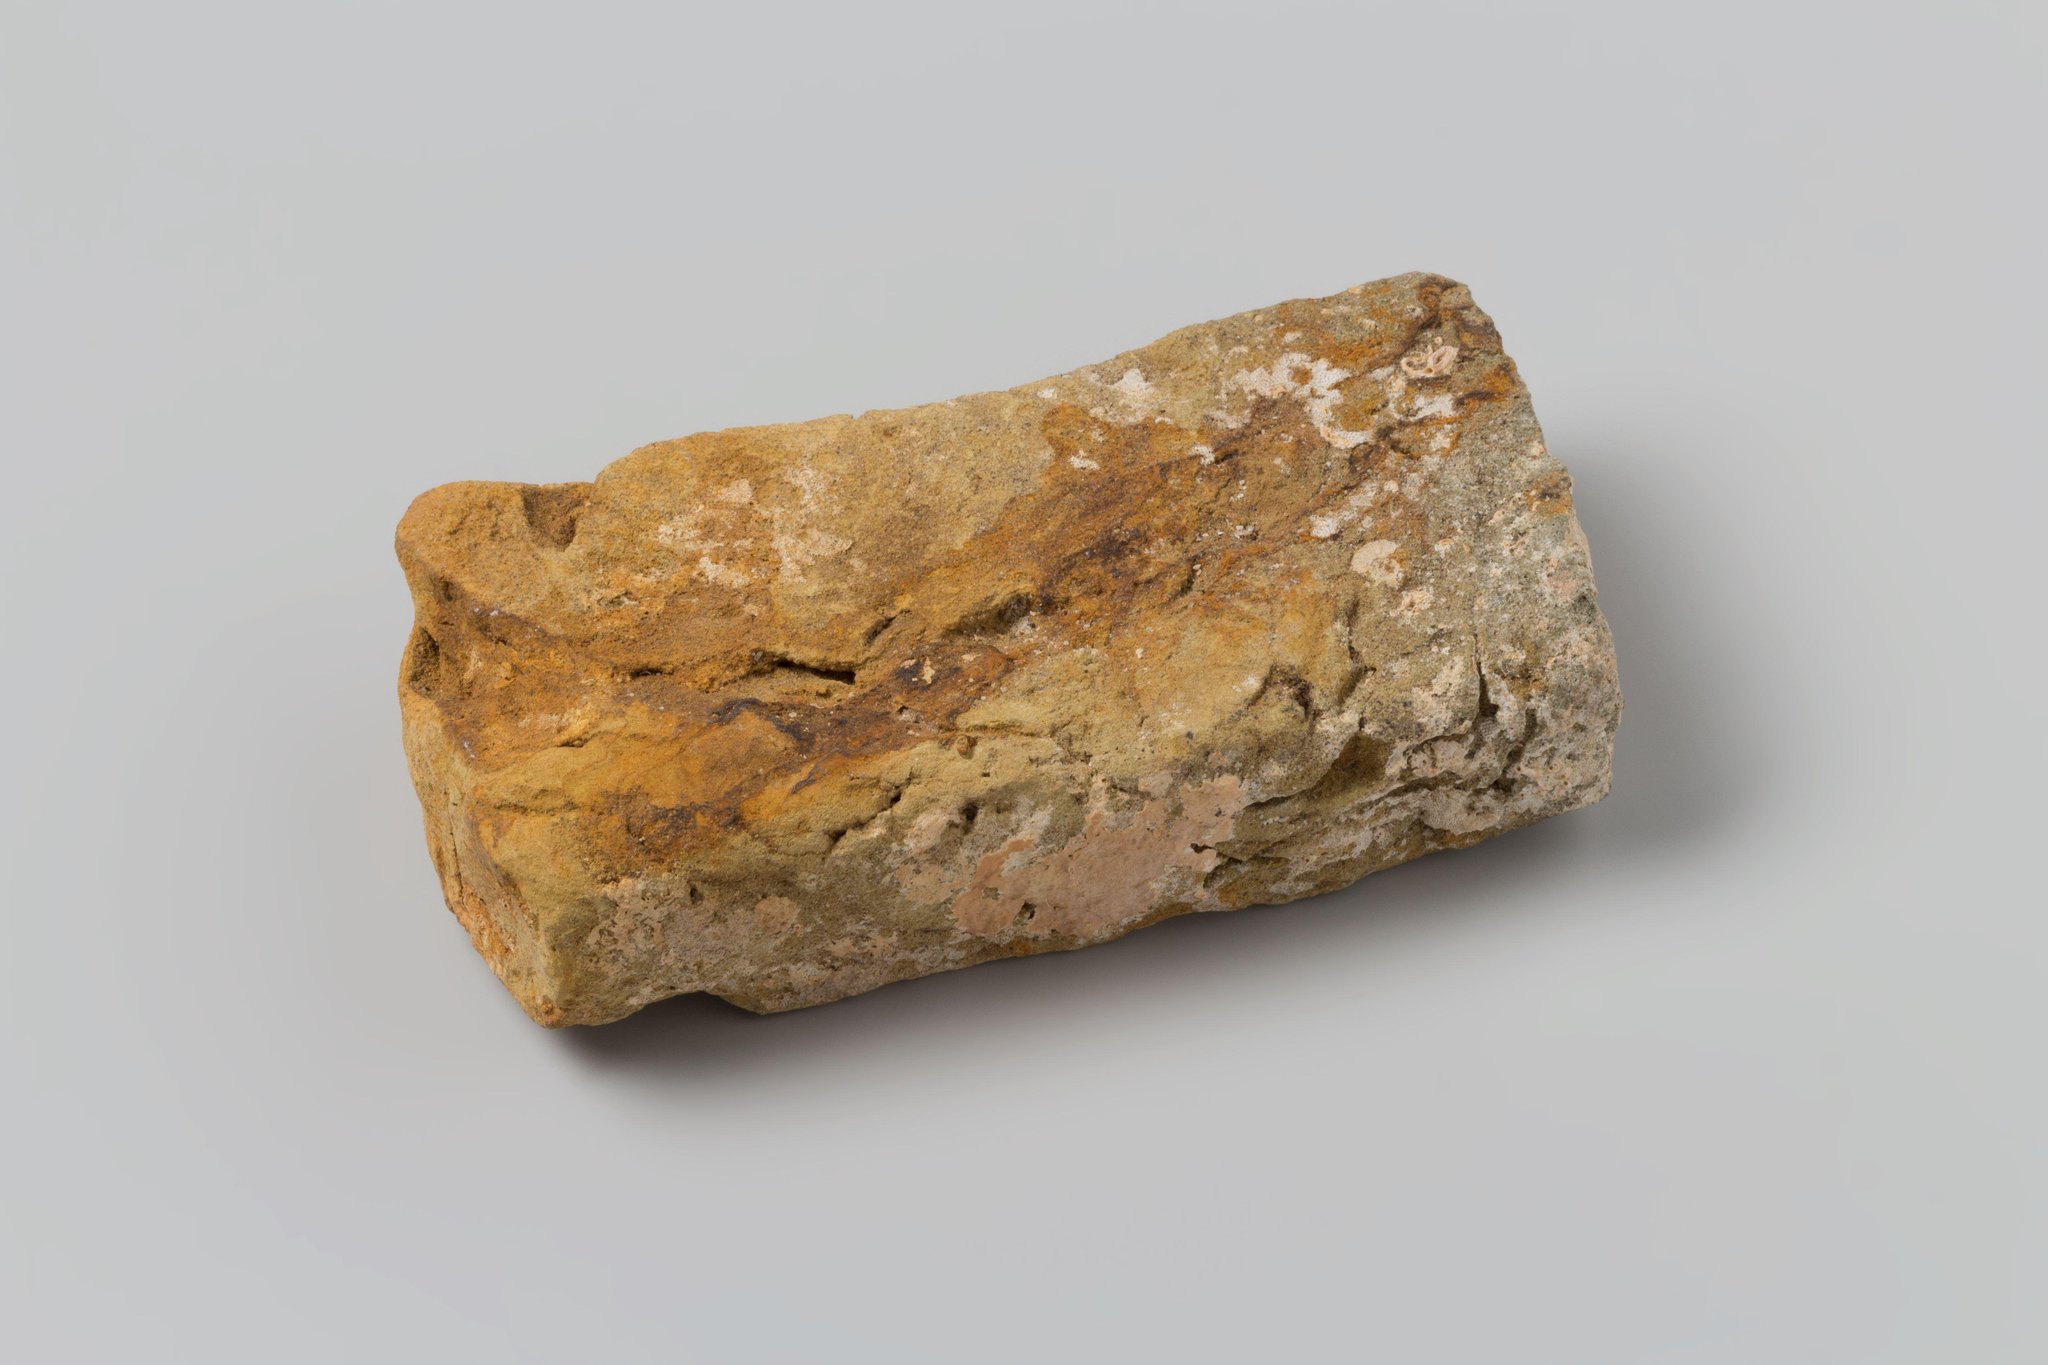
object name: brick clay product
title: Baksteen uit het wrak van de Oost-Indiëvaarder Hollandia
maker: Anonymous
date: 1700-1743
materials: brick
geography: netherlands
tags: verenigde oostindische compagnie, hollandia (schip), annet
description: Constructional elements, brick; rectangular.